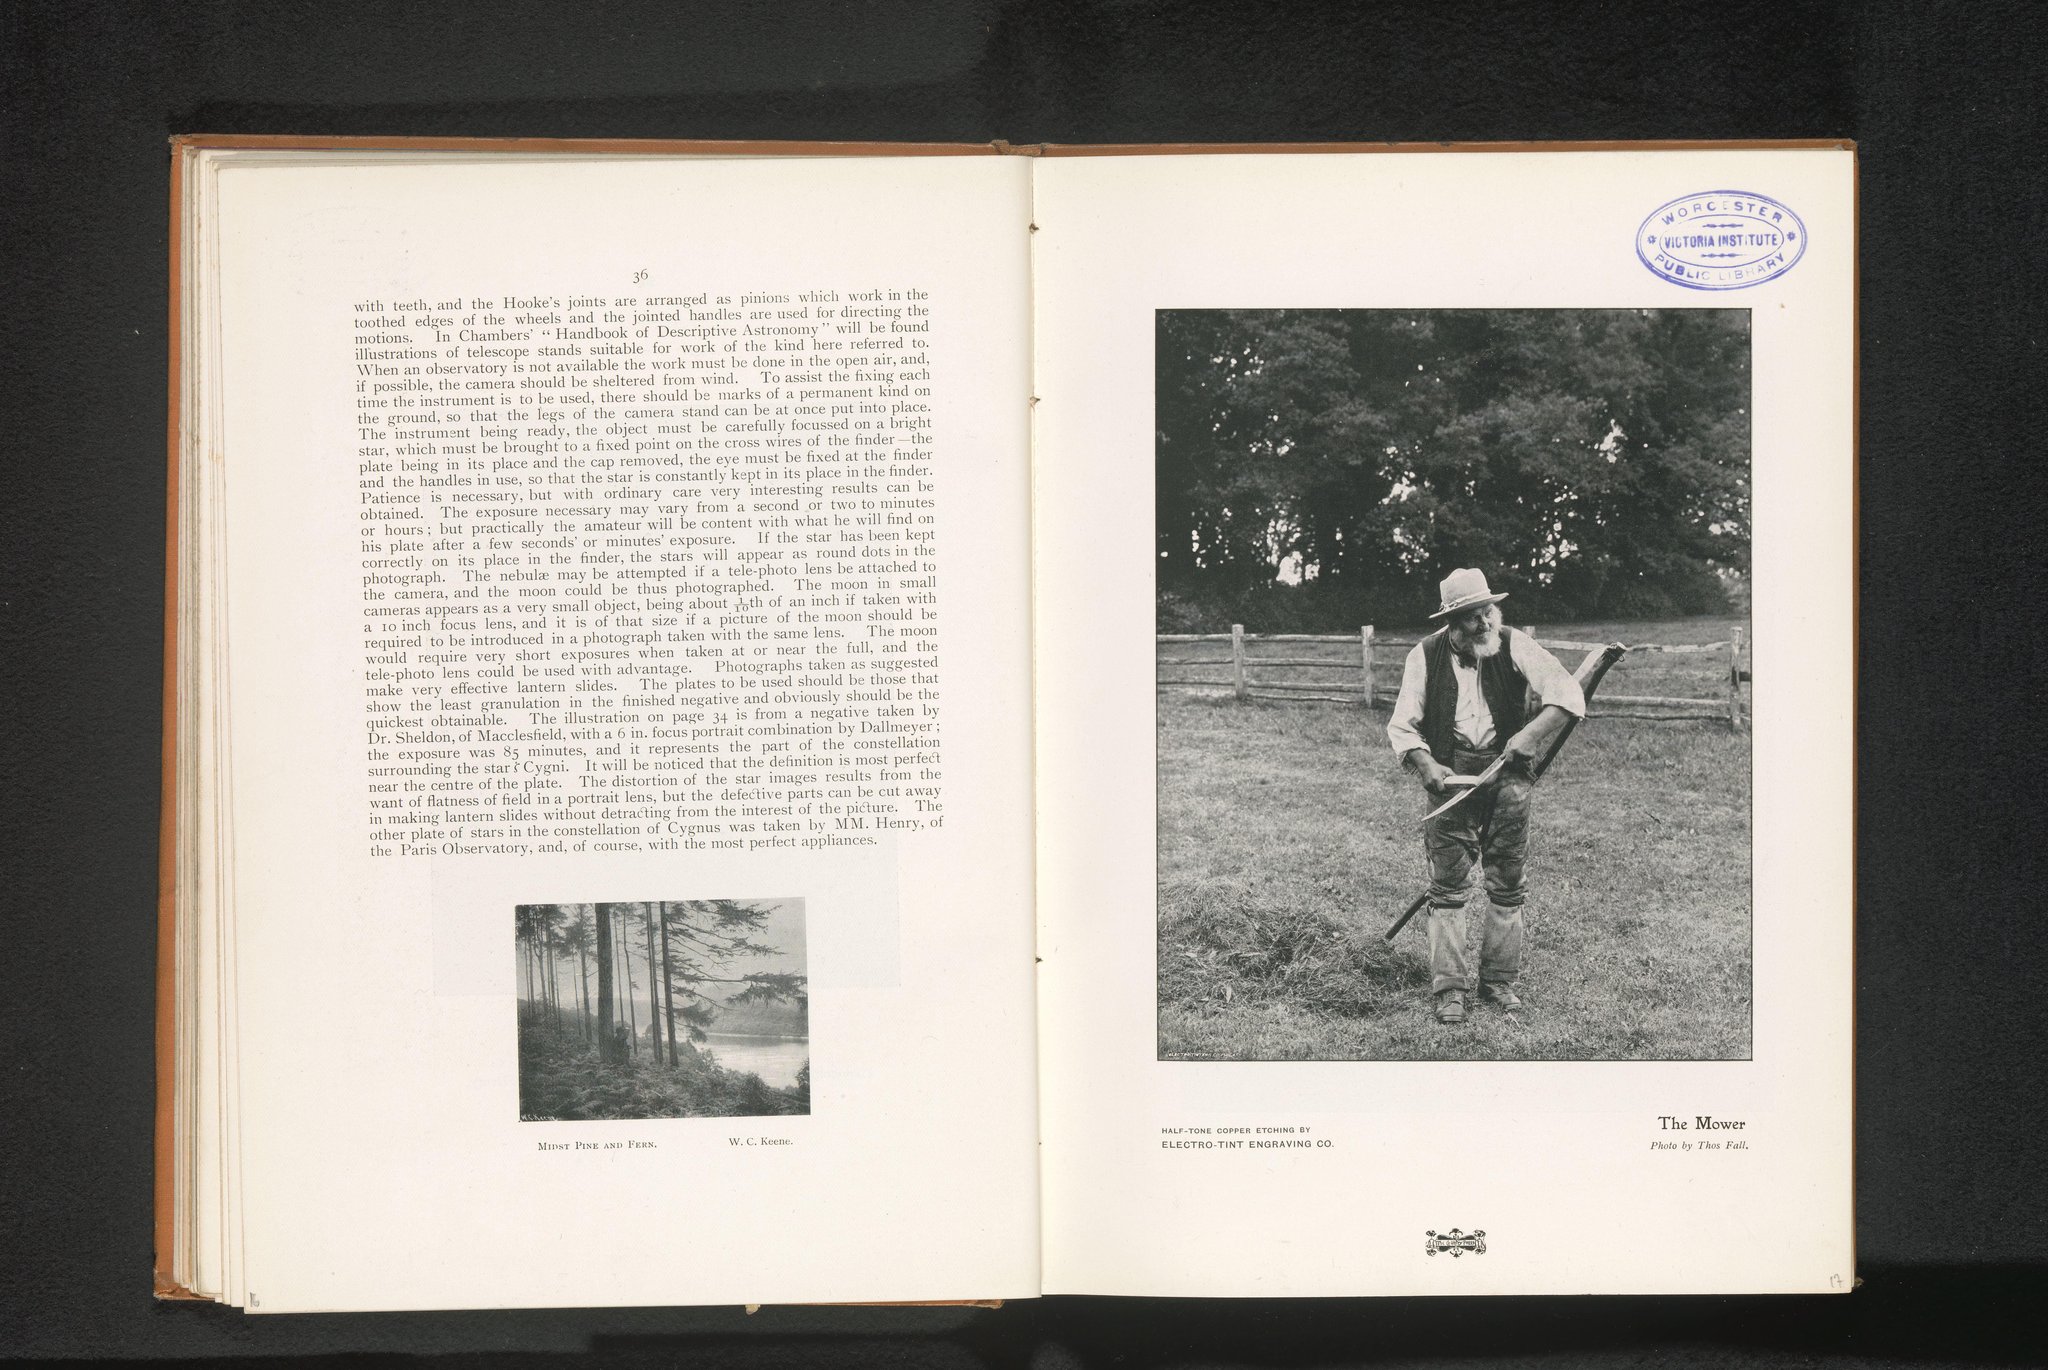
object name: page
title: The Mower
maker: thomas fall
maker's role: fotograaf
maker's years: 1833-1900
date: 1894-1899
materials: paper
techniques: autotype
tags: agricultural implements: scythe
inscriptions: collector's mark: ‘Worcester Public Library/ Victoria's Institute’